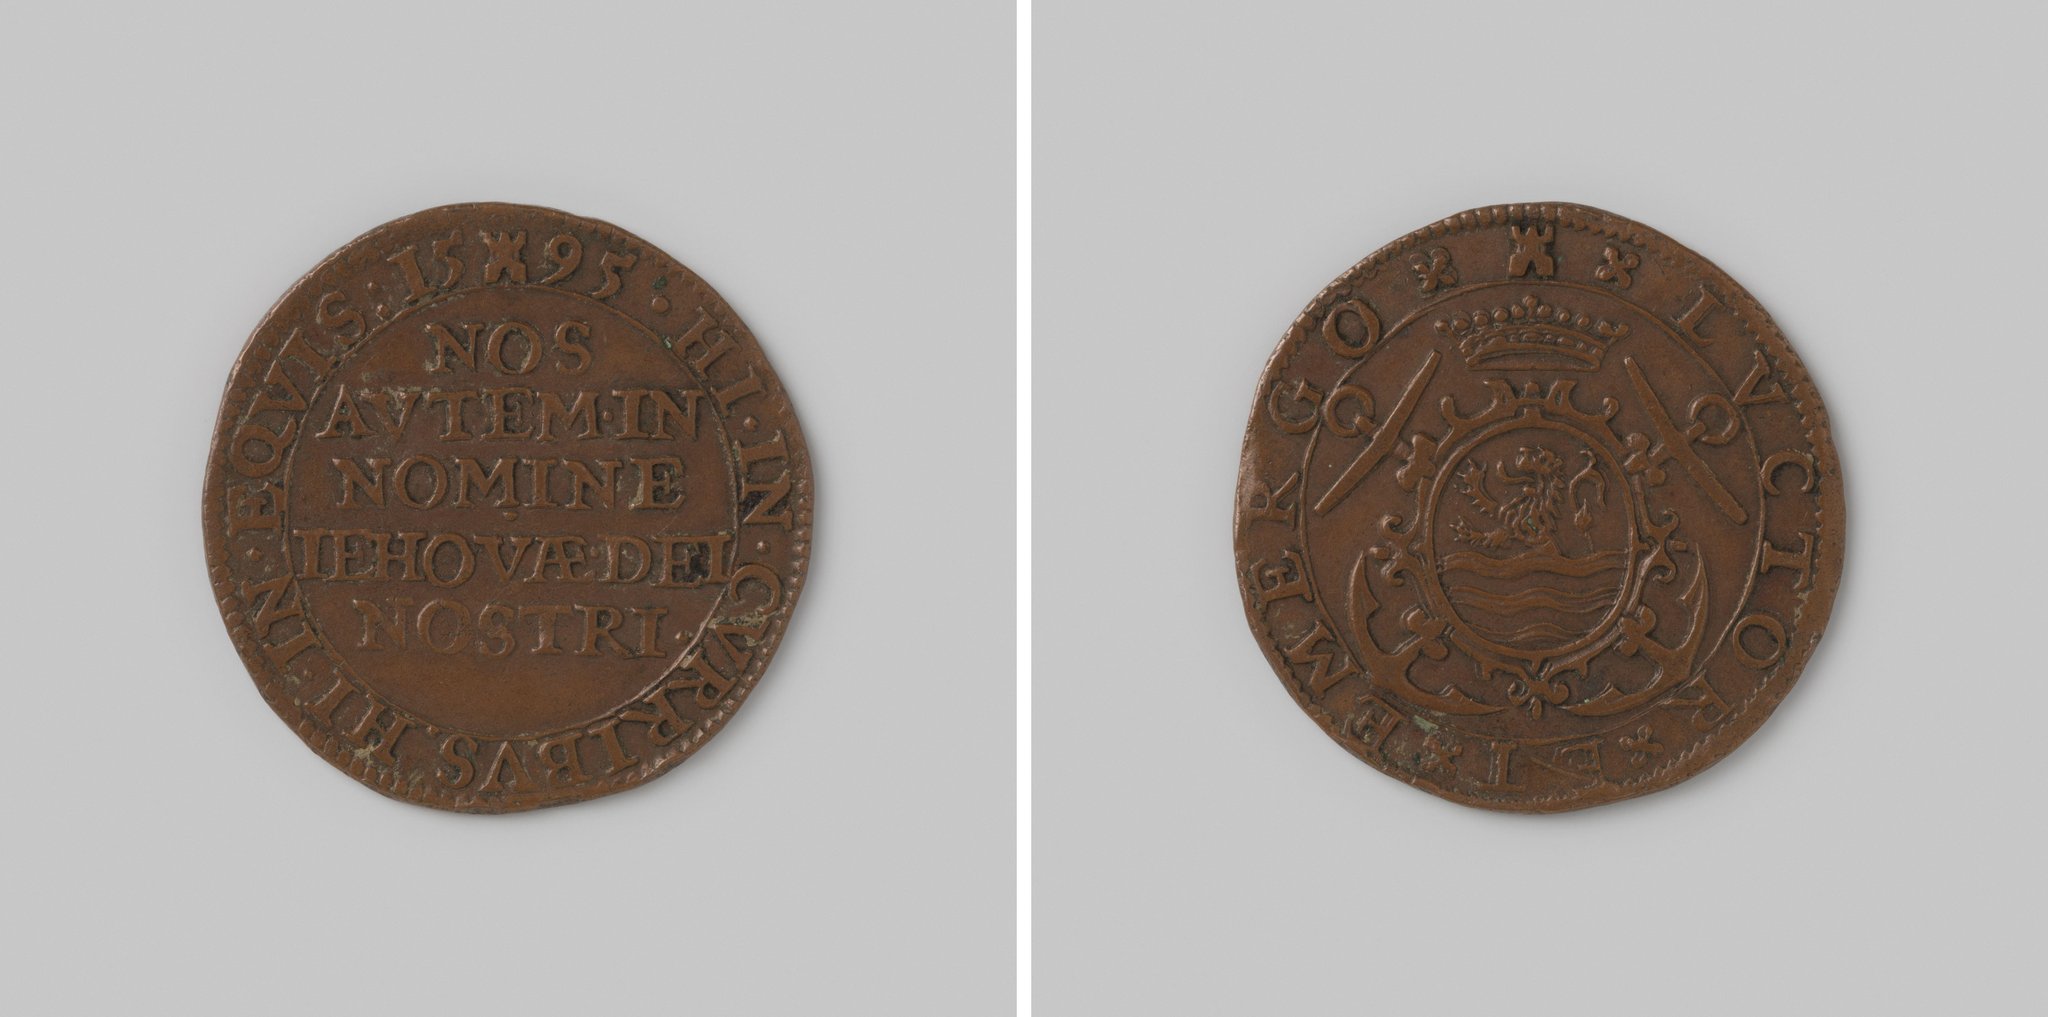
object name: jeton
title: Rekenpenning uit Middelburg op het Zeeuwse vertrouwen op God 1595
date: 1595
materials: copper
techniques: striking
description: Koperen penning, op de voorzijde vijf regels tekst met omschrift, op de keerzijde het gekroonde ovale wapenschild van Zeeland op twee gekruiste ankers, met omschrift.